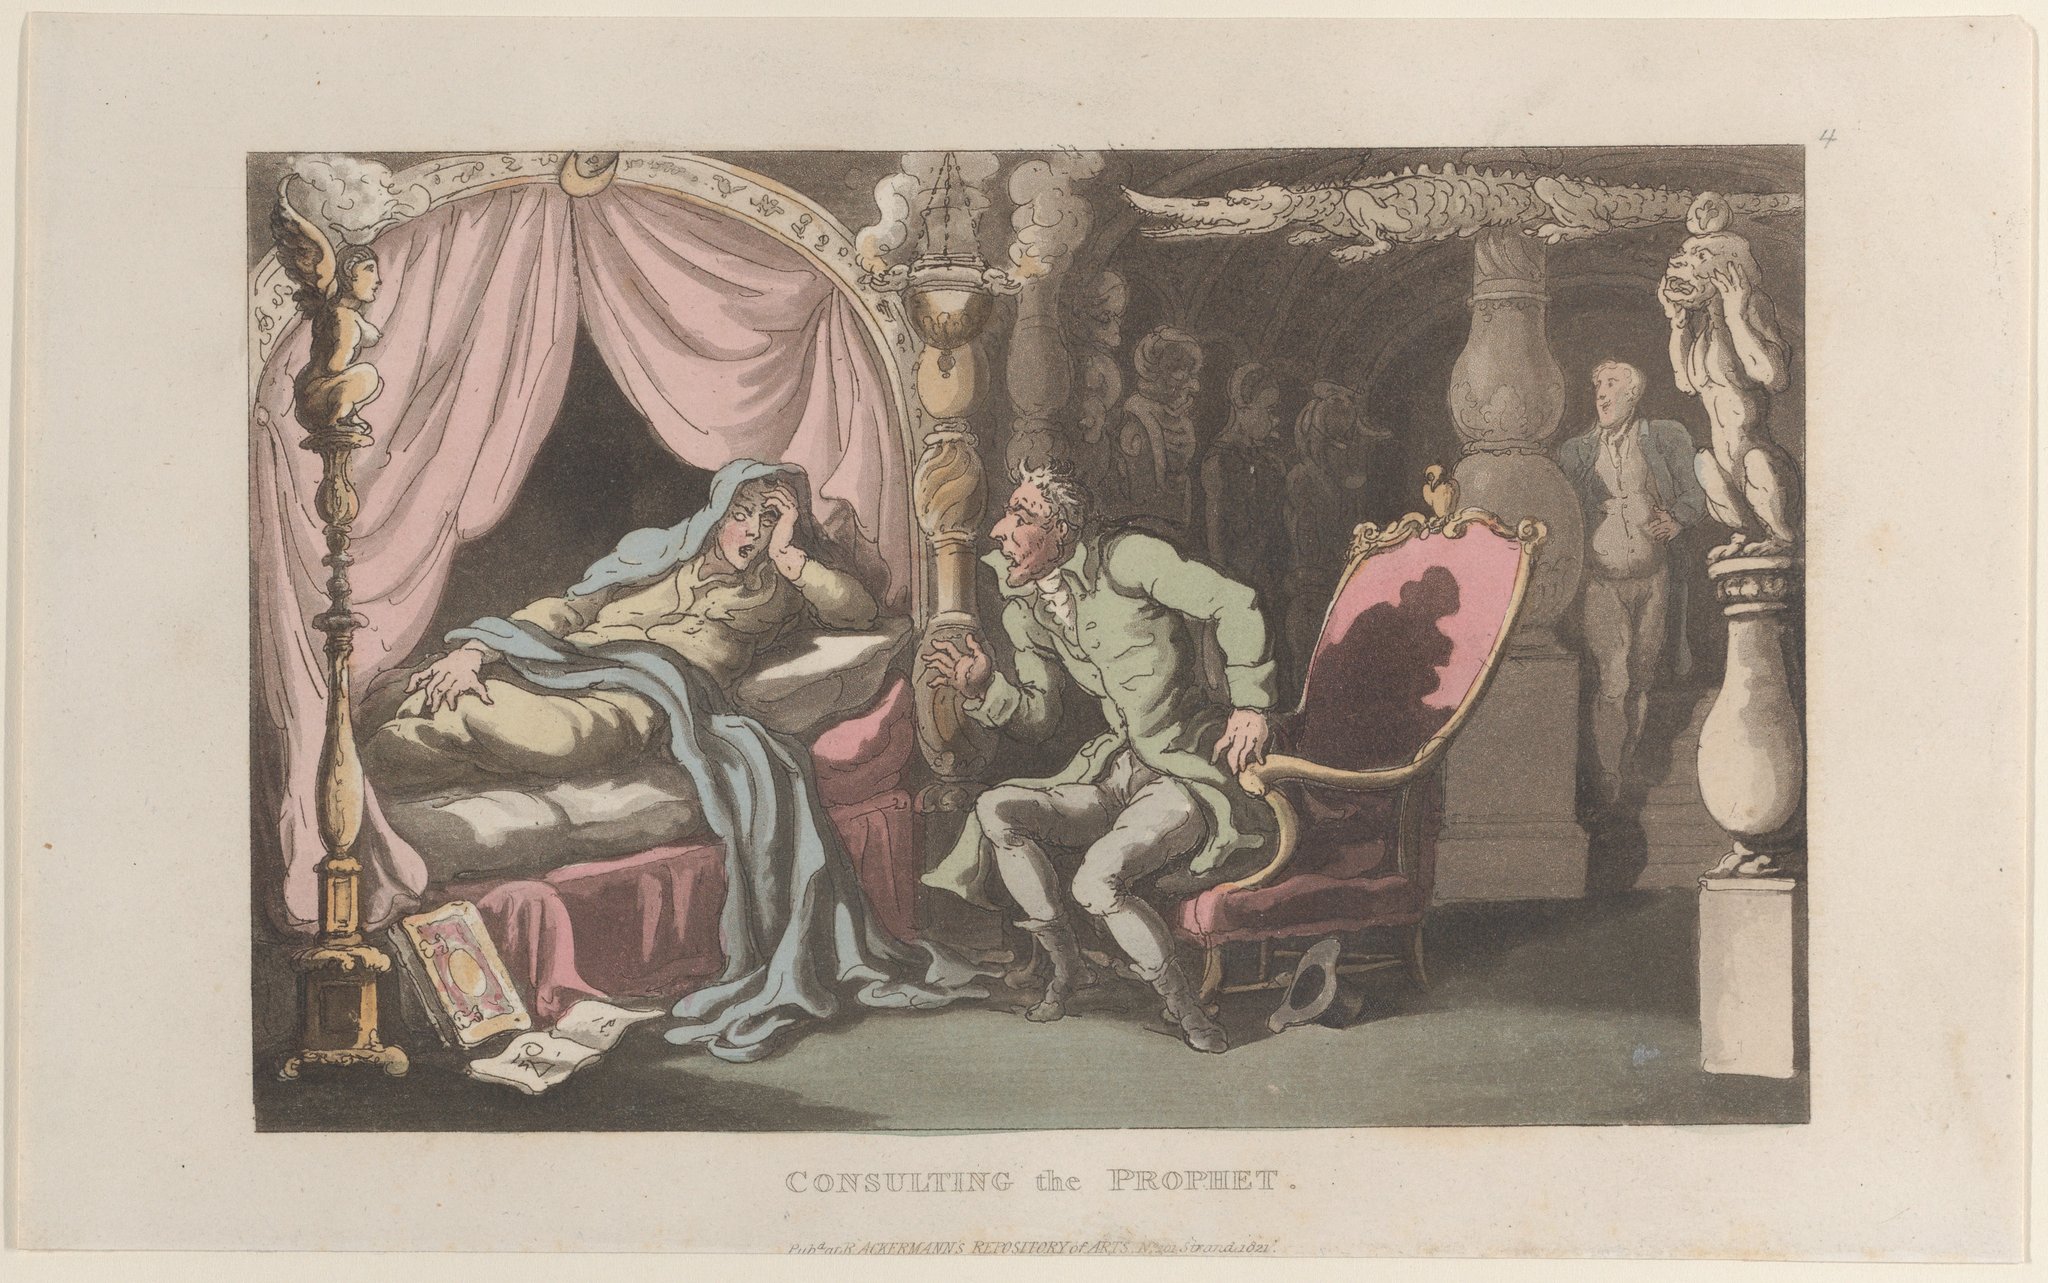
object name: print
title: Consulting the Prophet, from "Journal of Sentimental Travels in the Southern Provinces of France, Shortly Before the Revolution"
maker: thomas rowlandson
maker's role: artist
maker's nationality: british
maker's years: 1757-1827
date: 1821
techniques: aquatint, etching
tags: men,crocodiles